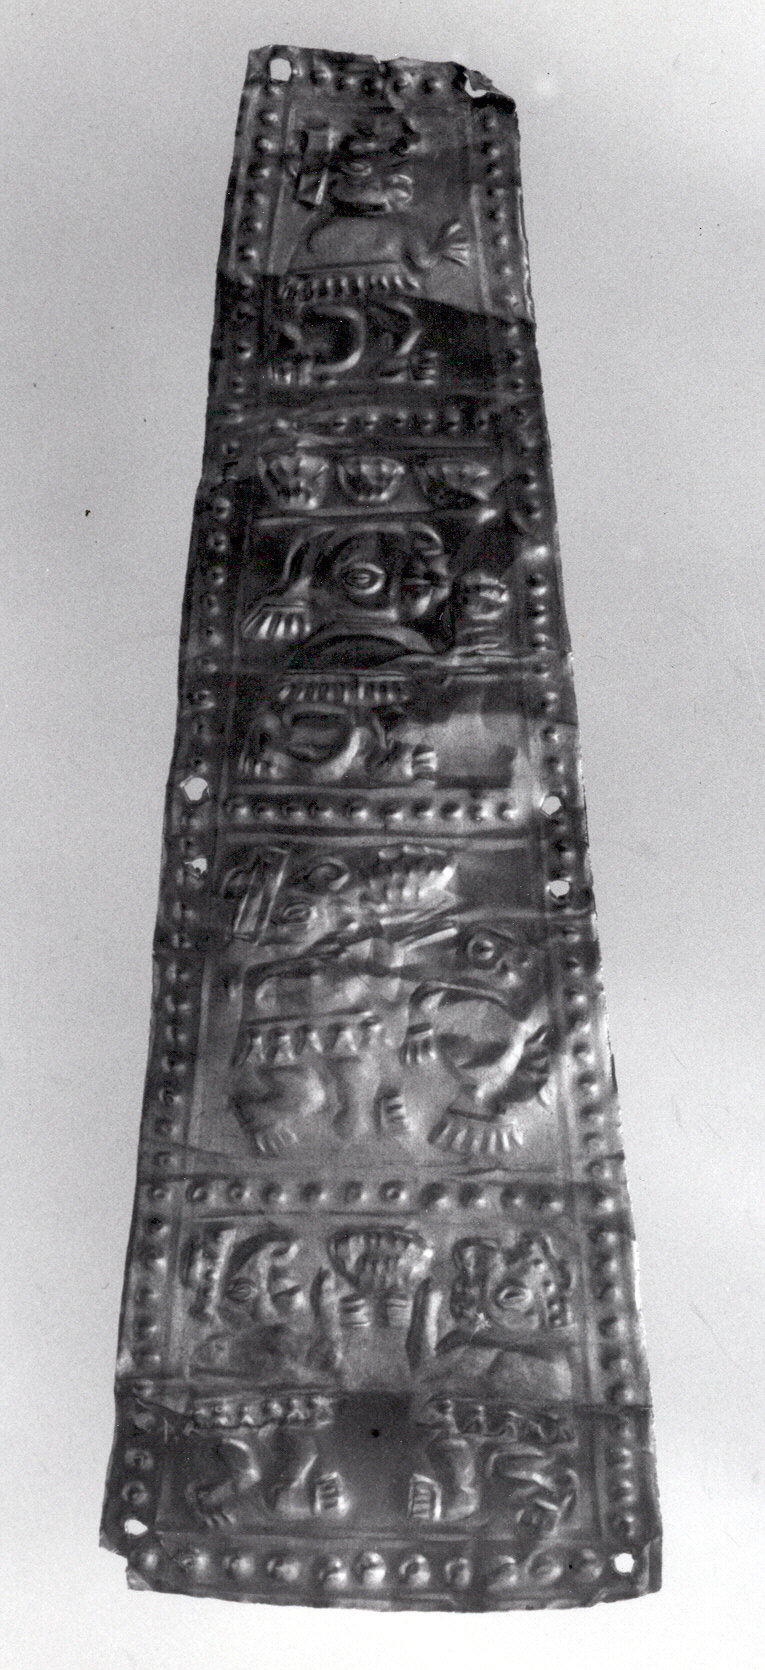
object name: sheathing fragment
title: Hammered Gold Sheathing Fragment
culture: chimú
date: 1101-1500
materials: gold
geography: peru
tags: human figures